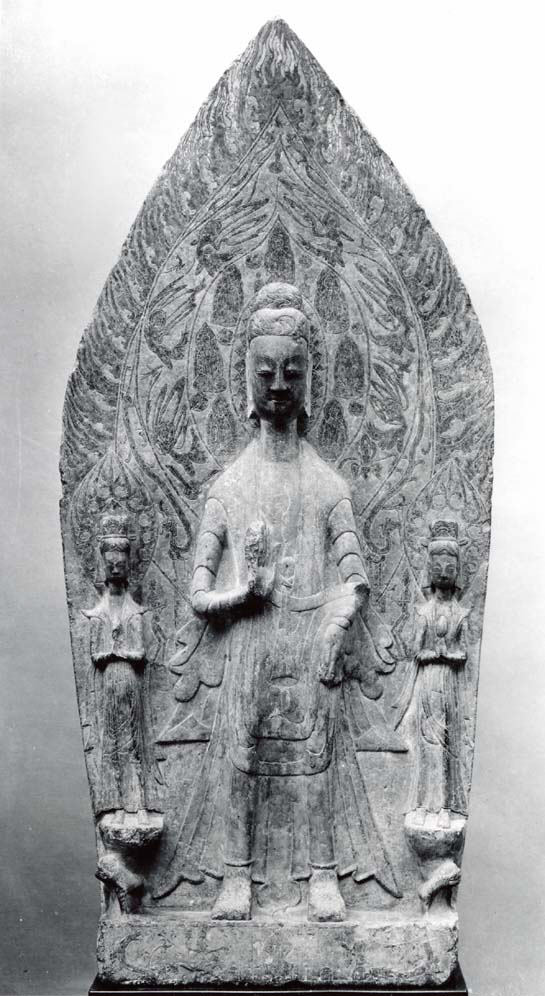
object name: stele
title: Maitreya with attendant bodhisattvas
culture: chinese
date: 386-534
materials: limestone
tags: buddhism,bodhisattvas,buddha